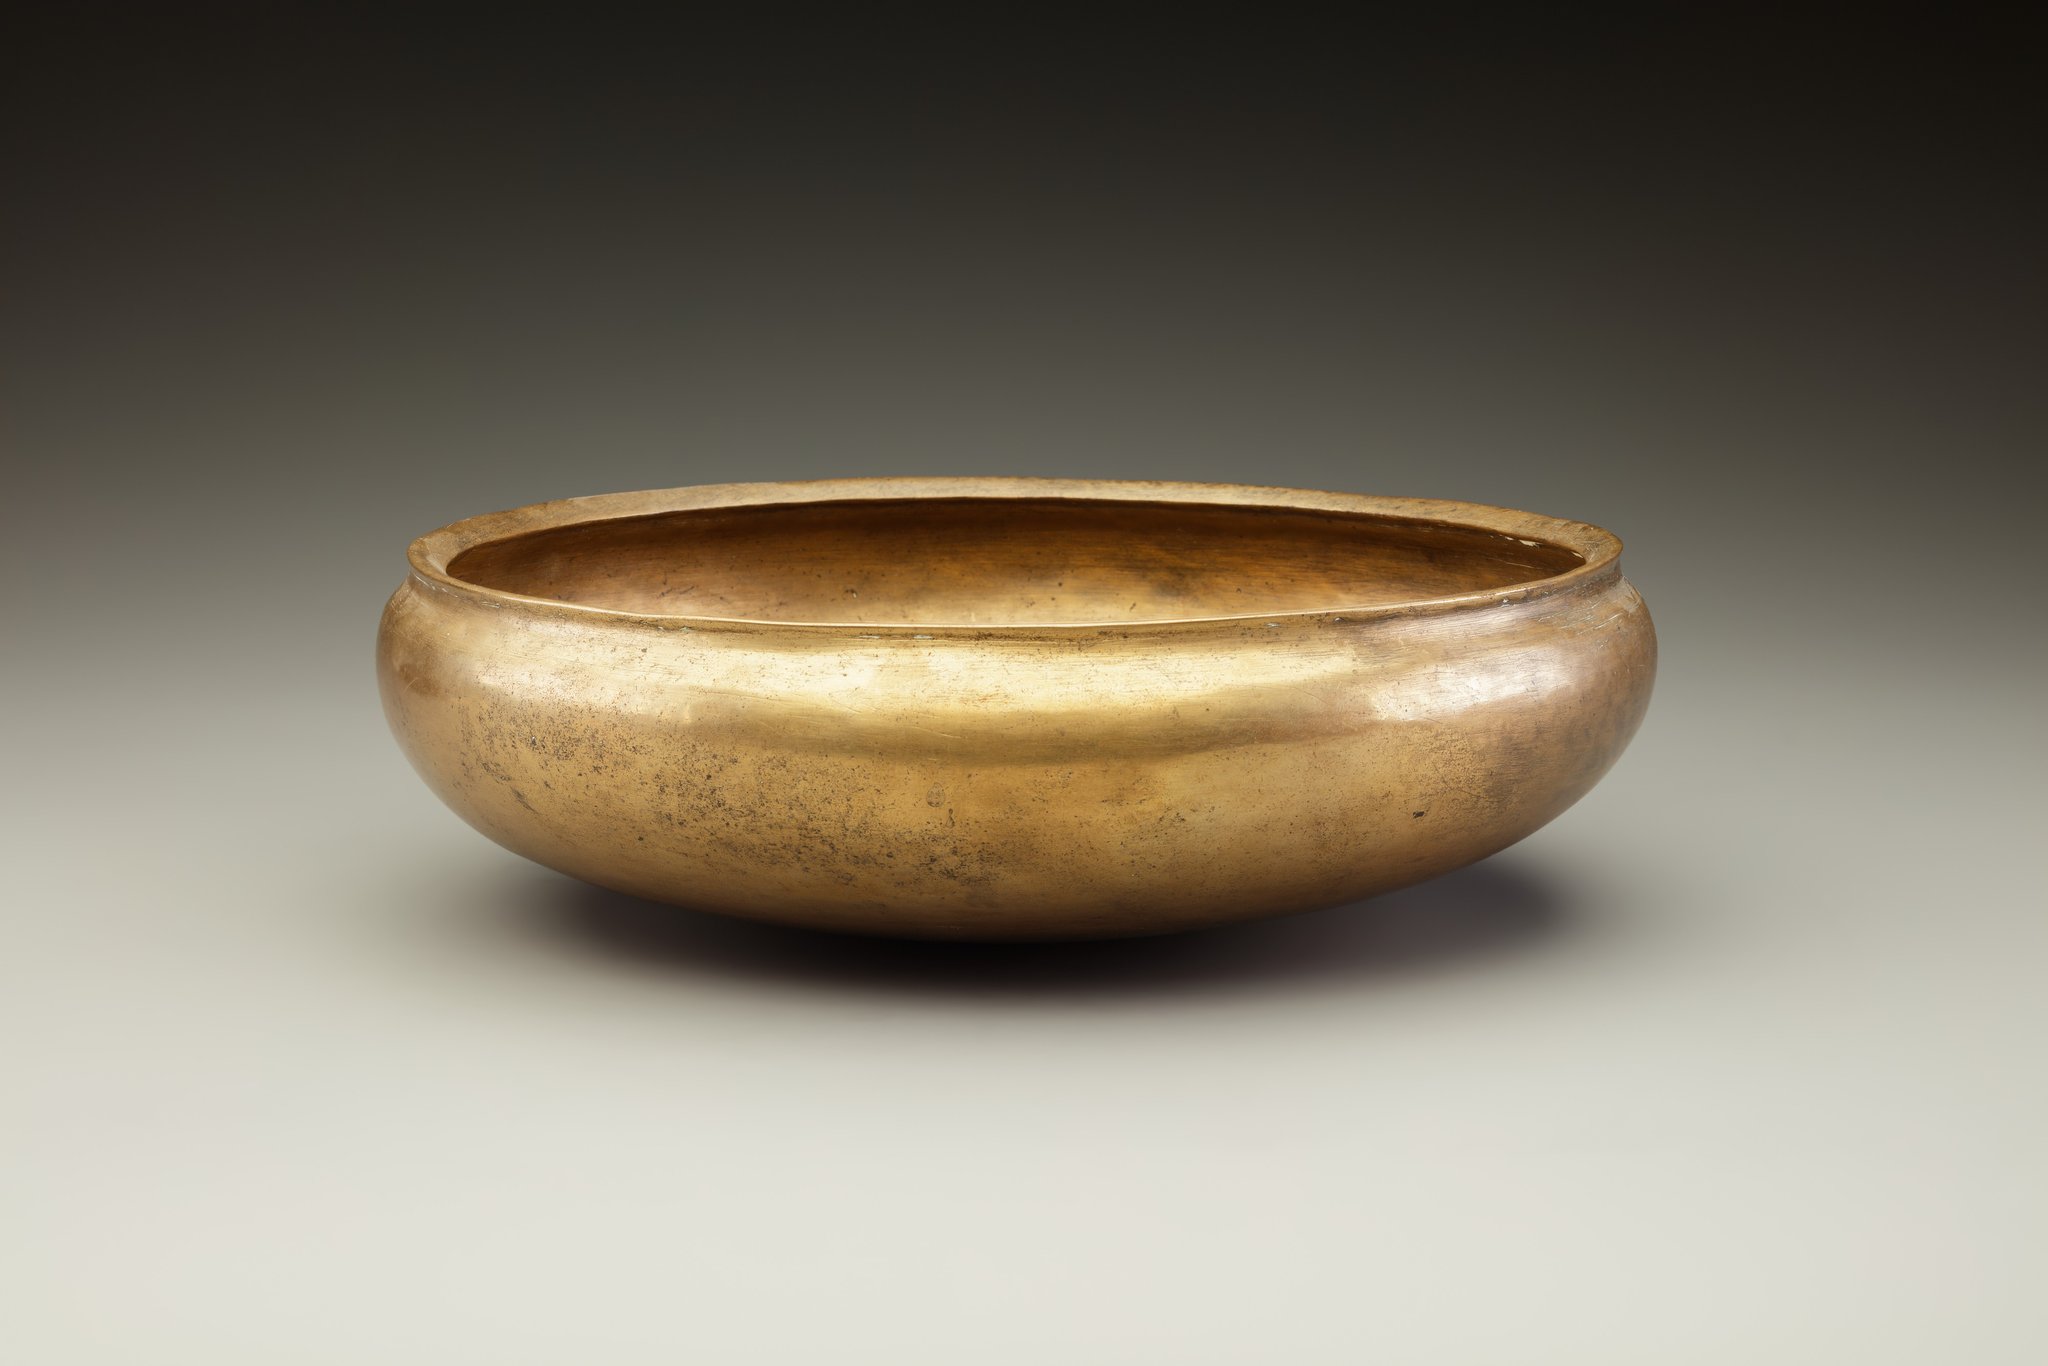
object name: bowl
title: One of five bowls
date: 1295-1070 BCE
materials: bronze, copper alloy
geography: egypt